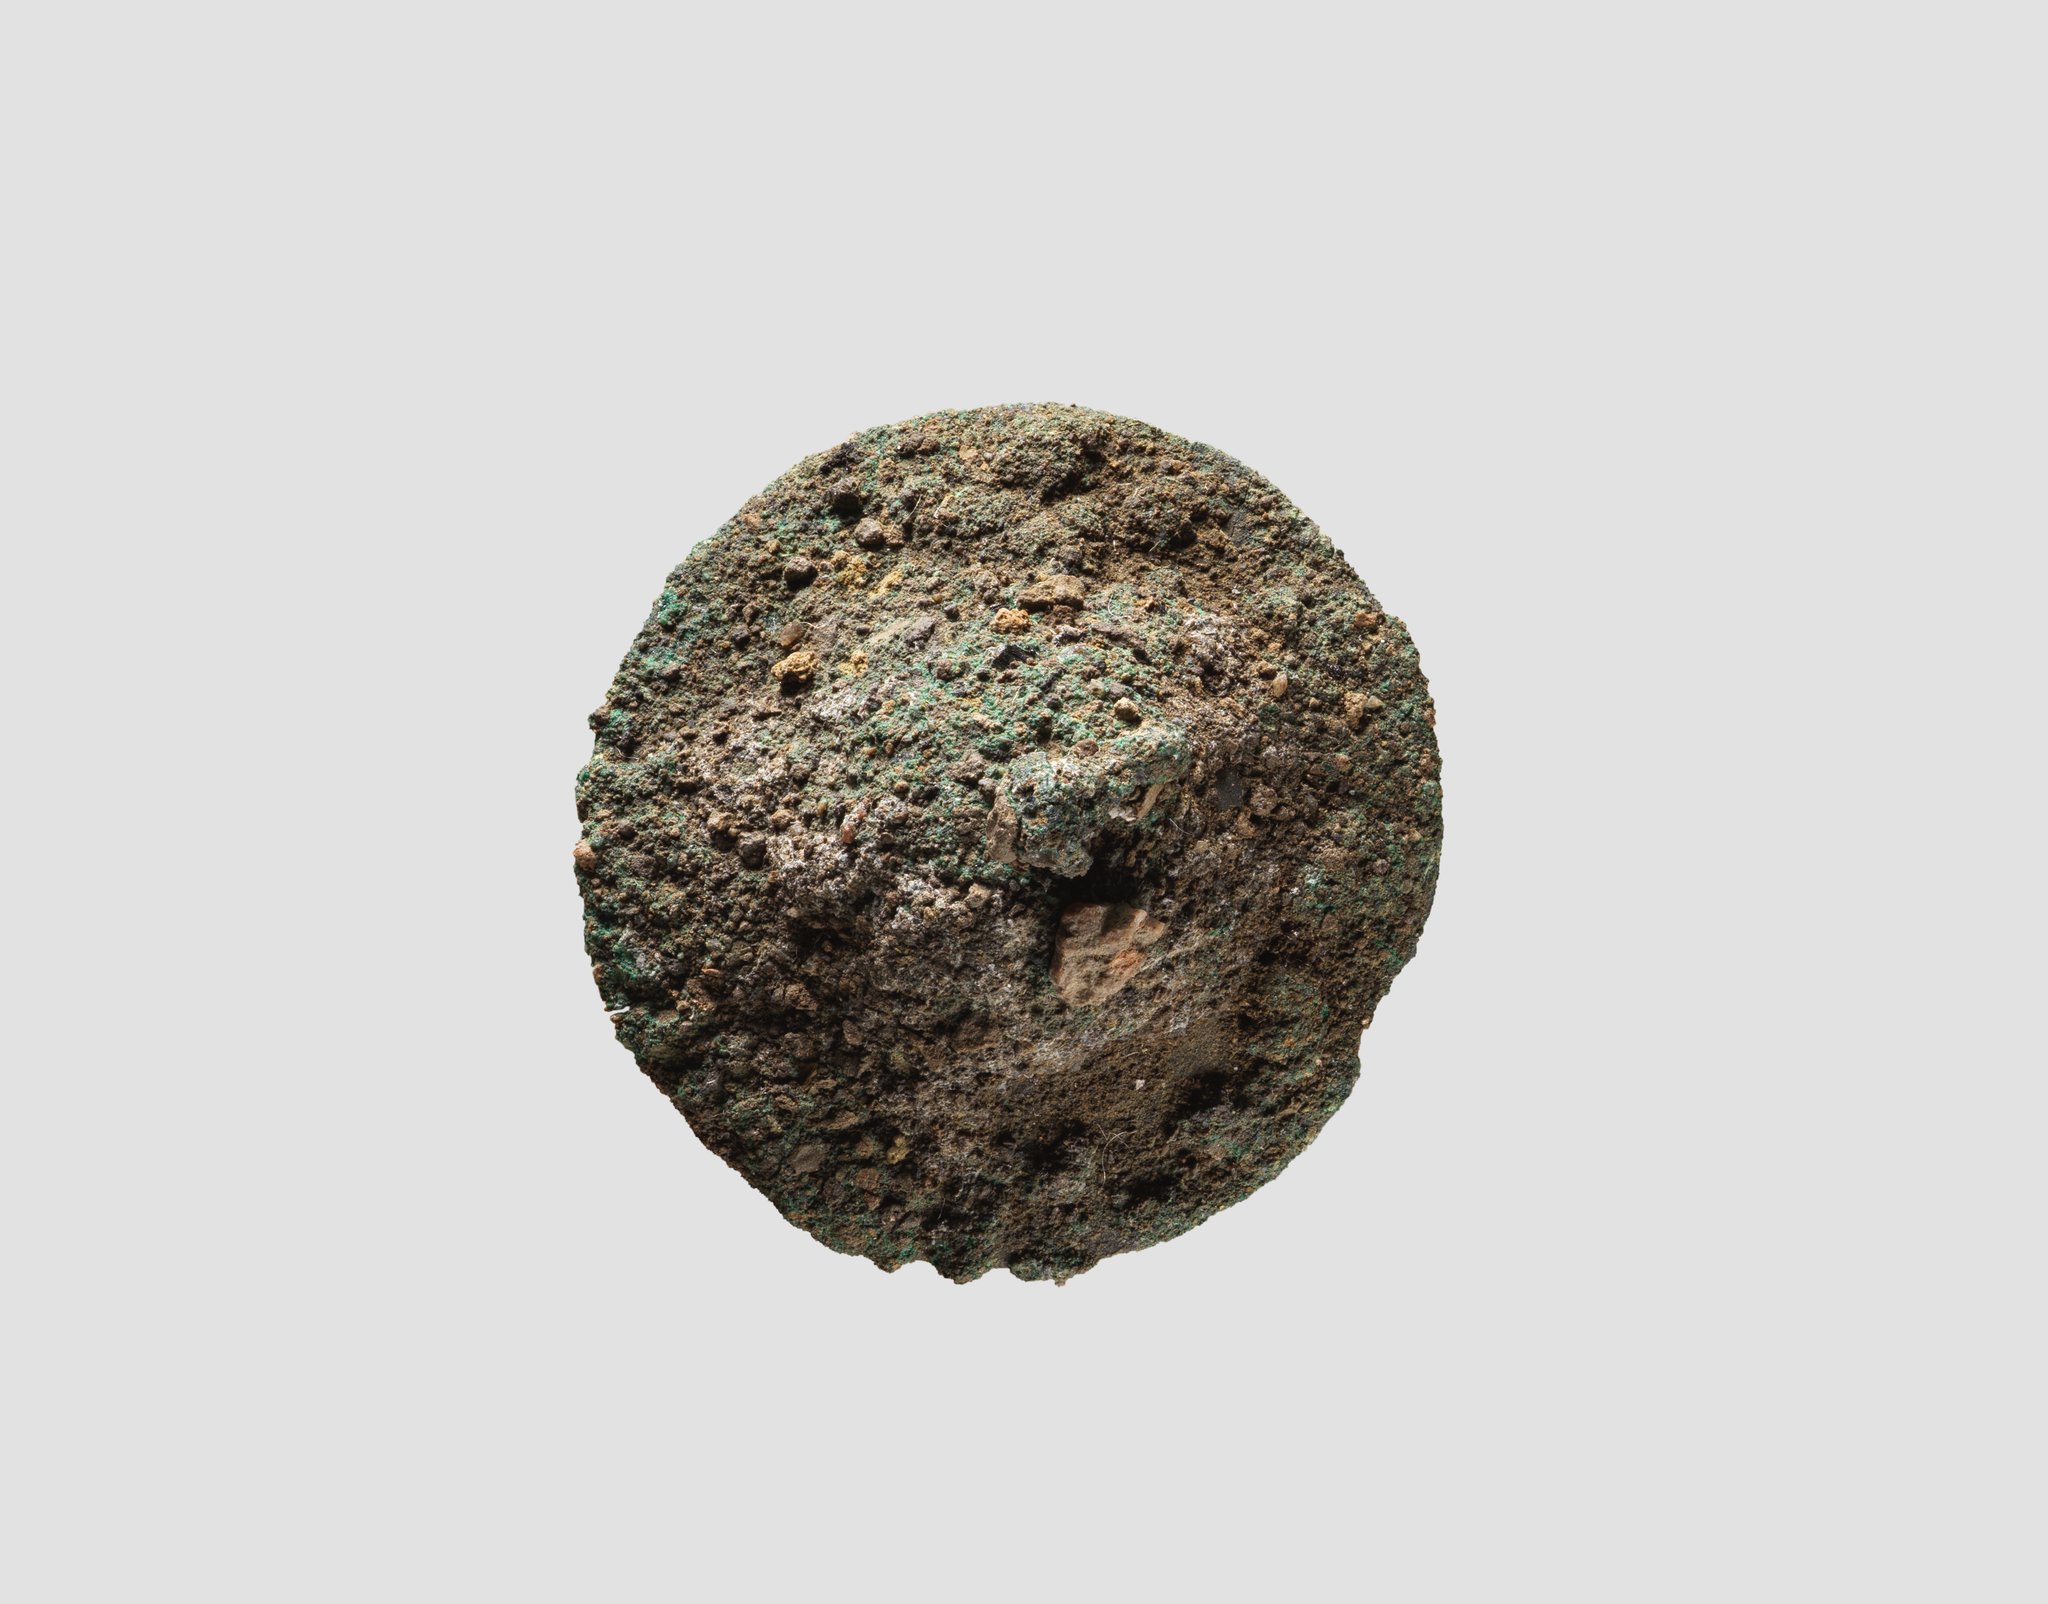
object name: stud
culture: iranian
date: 900-801 BCE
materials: bronze, copper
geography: iran